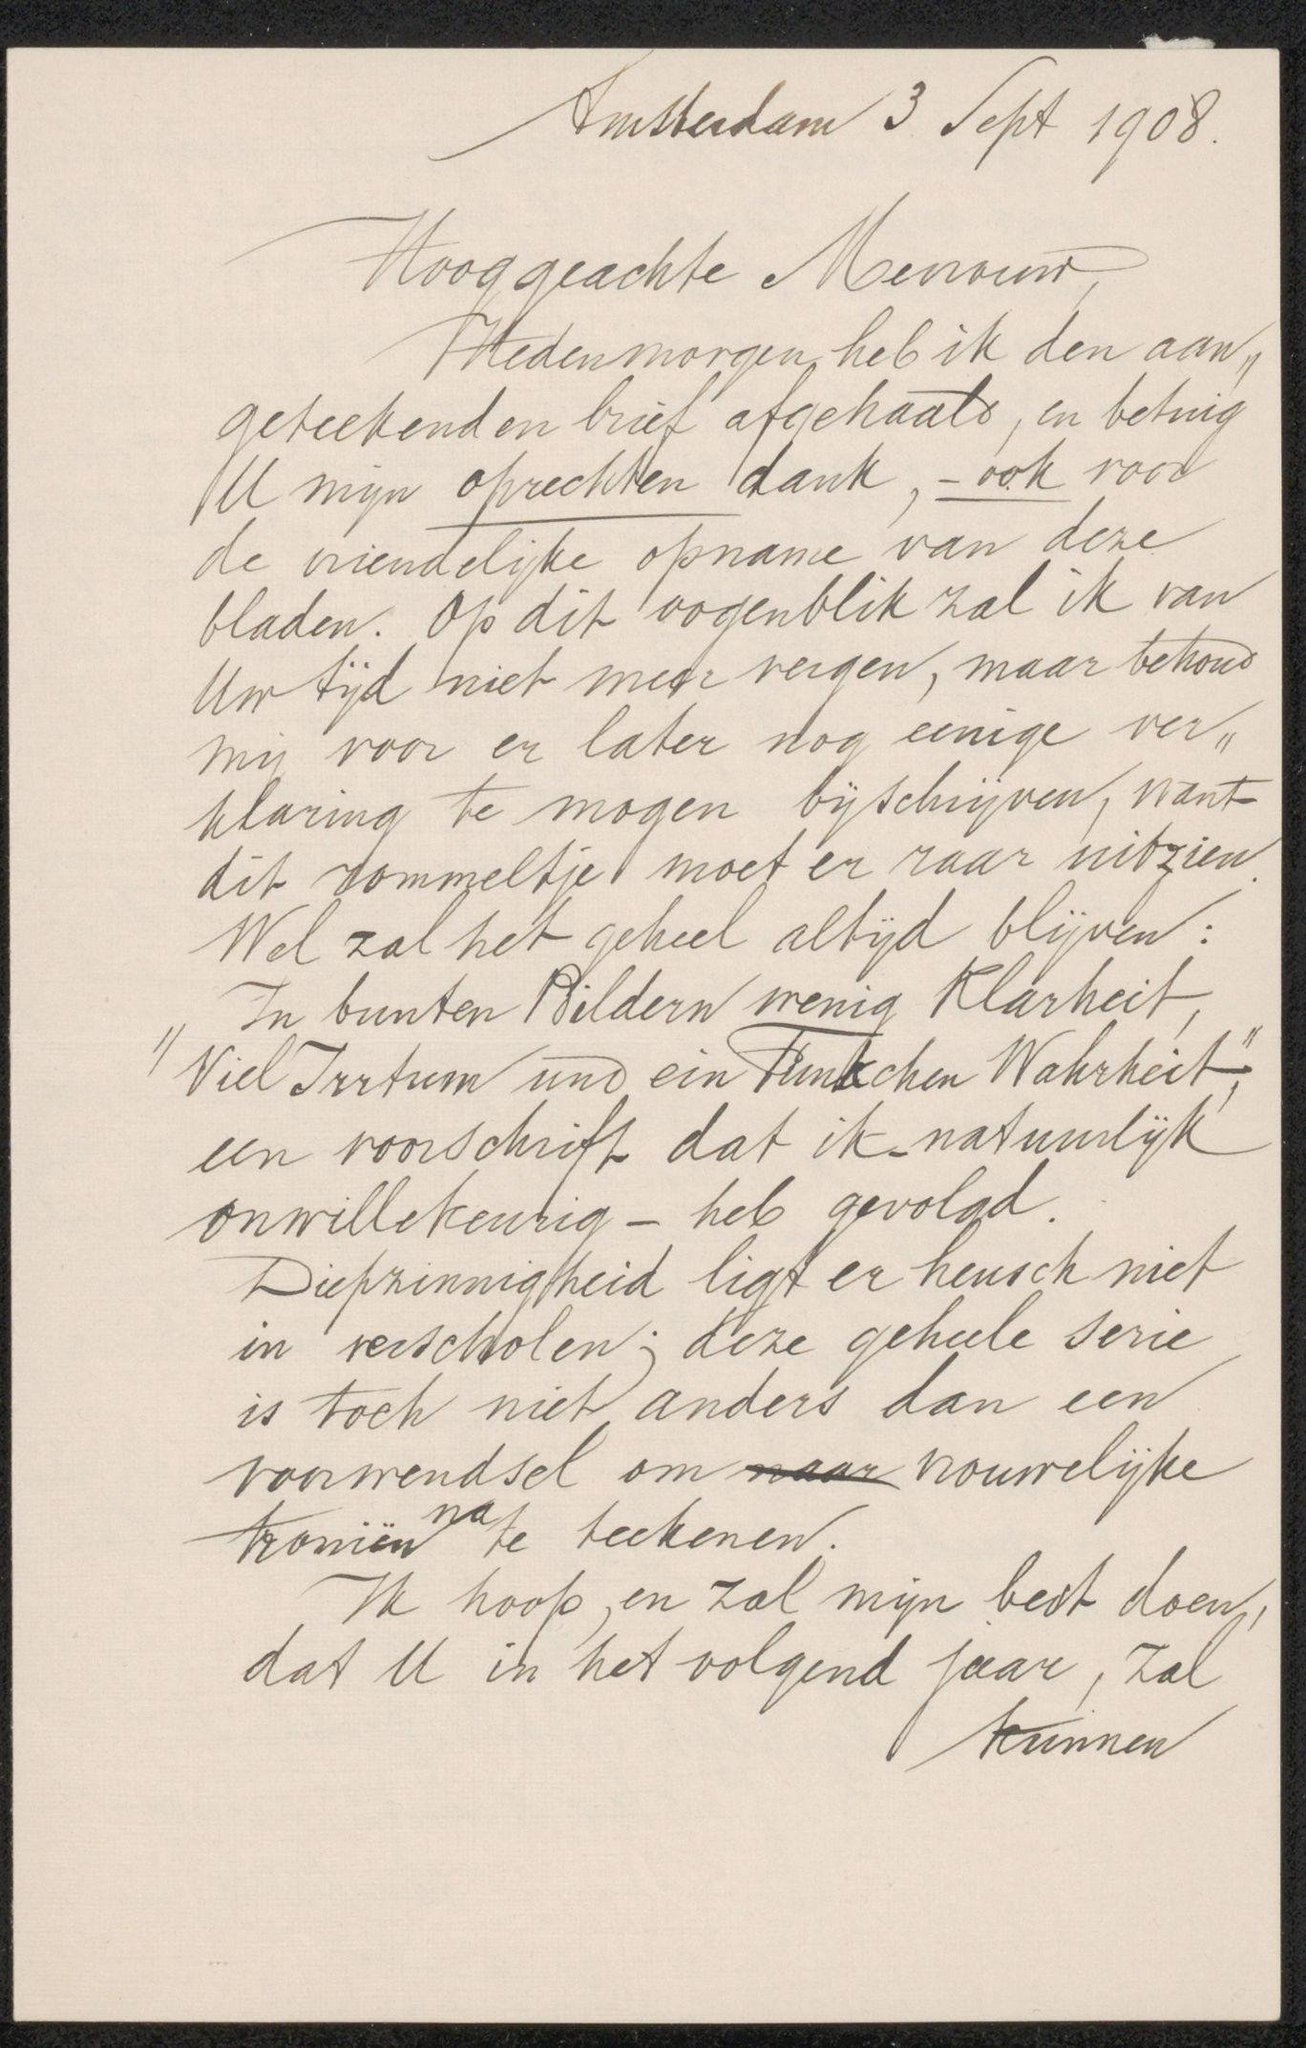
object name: letter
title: Brief aan Anne Antoinette Weber-Van Bosse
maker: august allebé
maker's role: draughtsman, print maker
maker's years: 1838-1927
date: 1908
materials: ink, paper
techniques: pen, writing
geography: amsterdam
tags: anne antoinette weber-van bosse, drawing